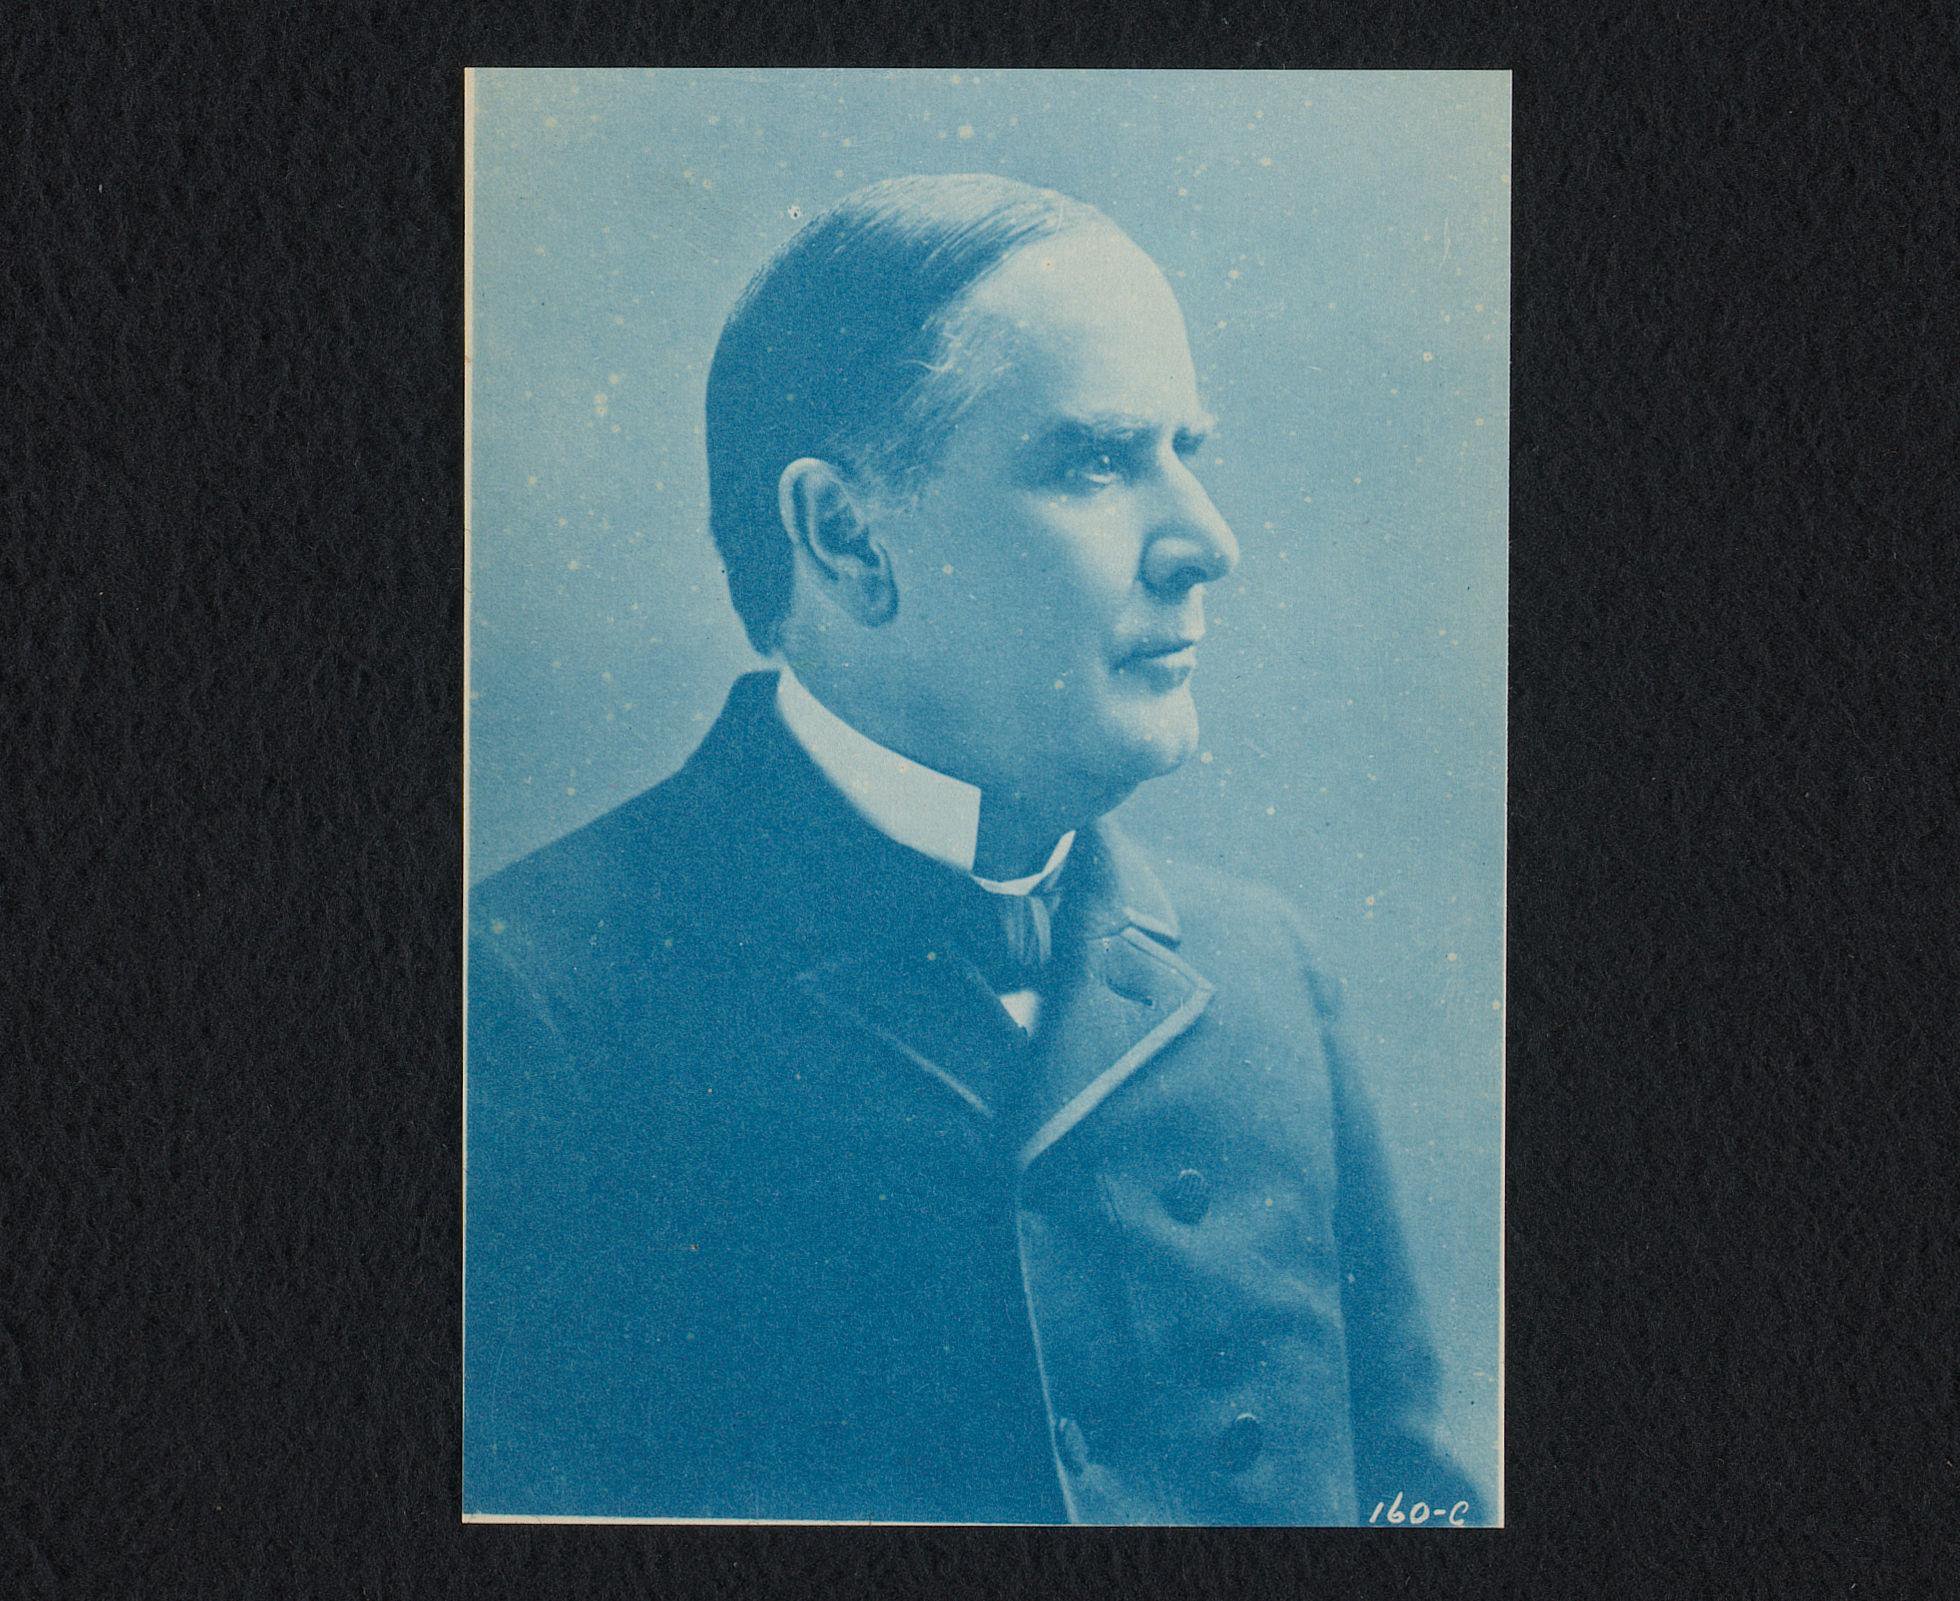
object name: photograph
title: Portret van een onbekende man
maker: Anonymous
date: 1901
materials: paper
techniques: cyanotype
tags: historical persons not known by name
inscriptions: number: ‘160-C’